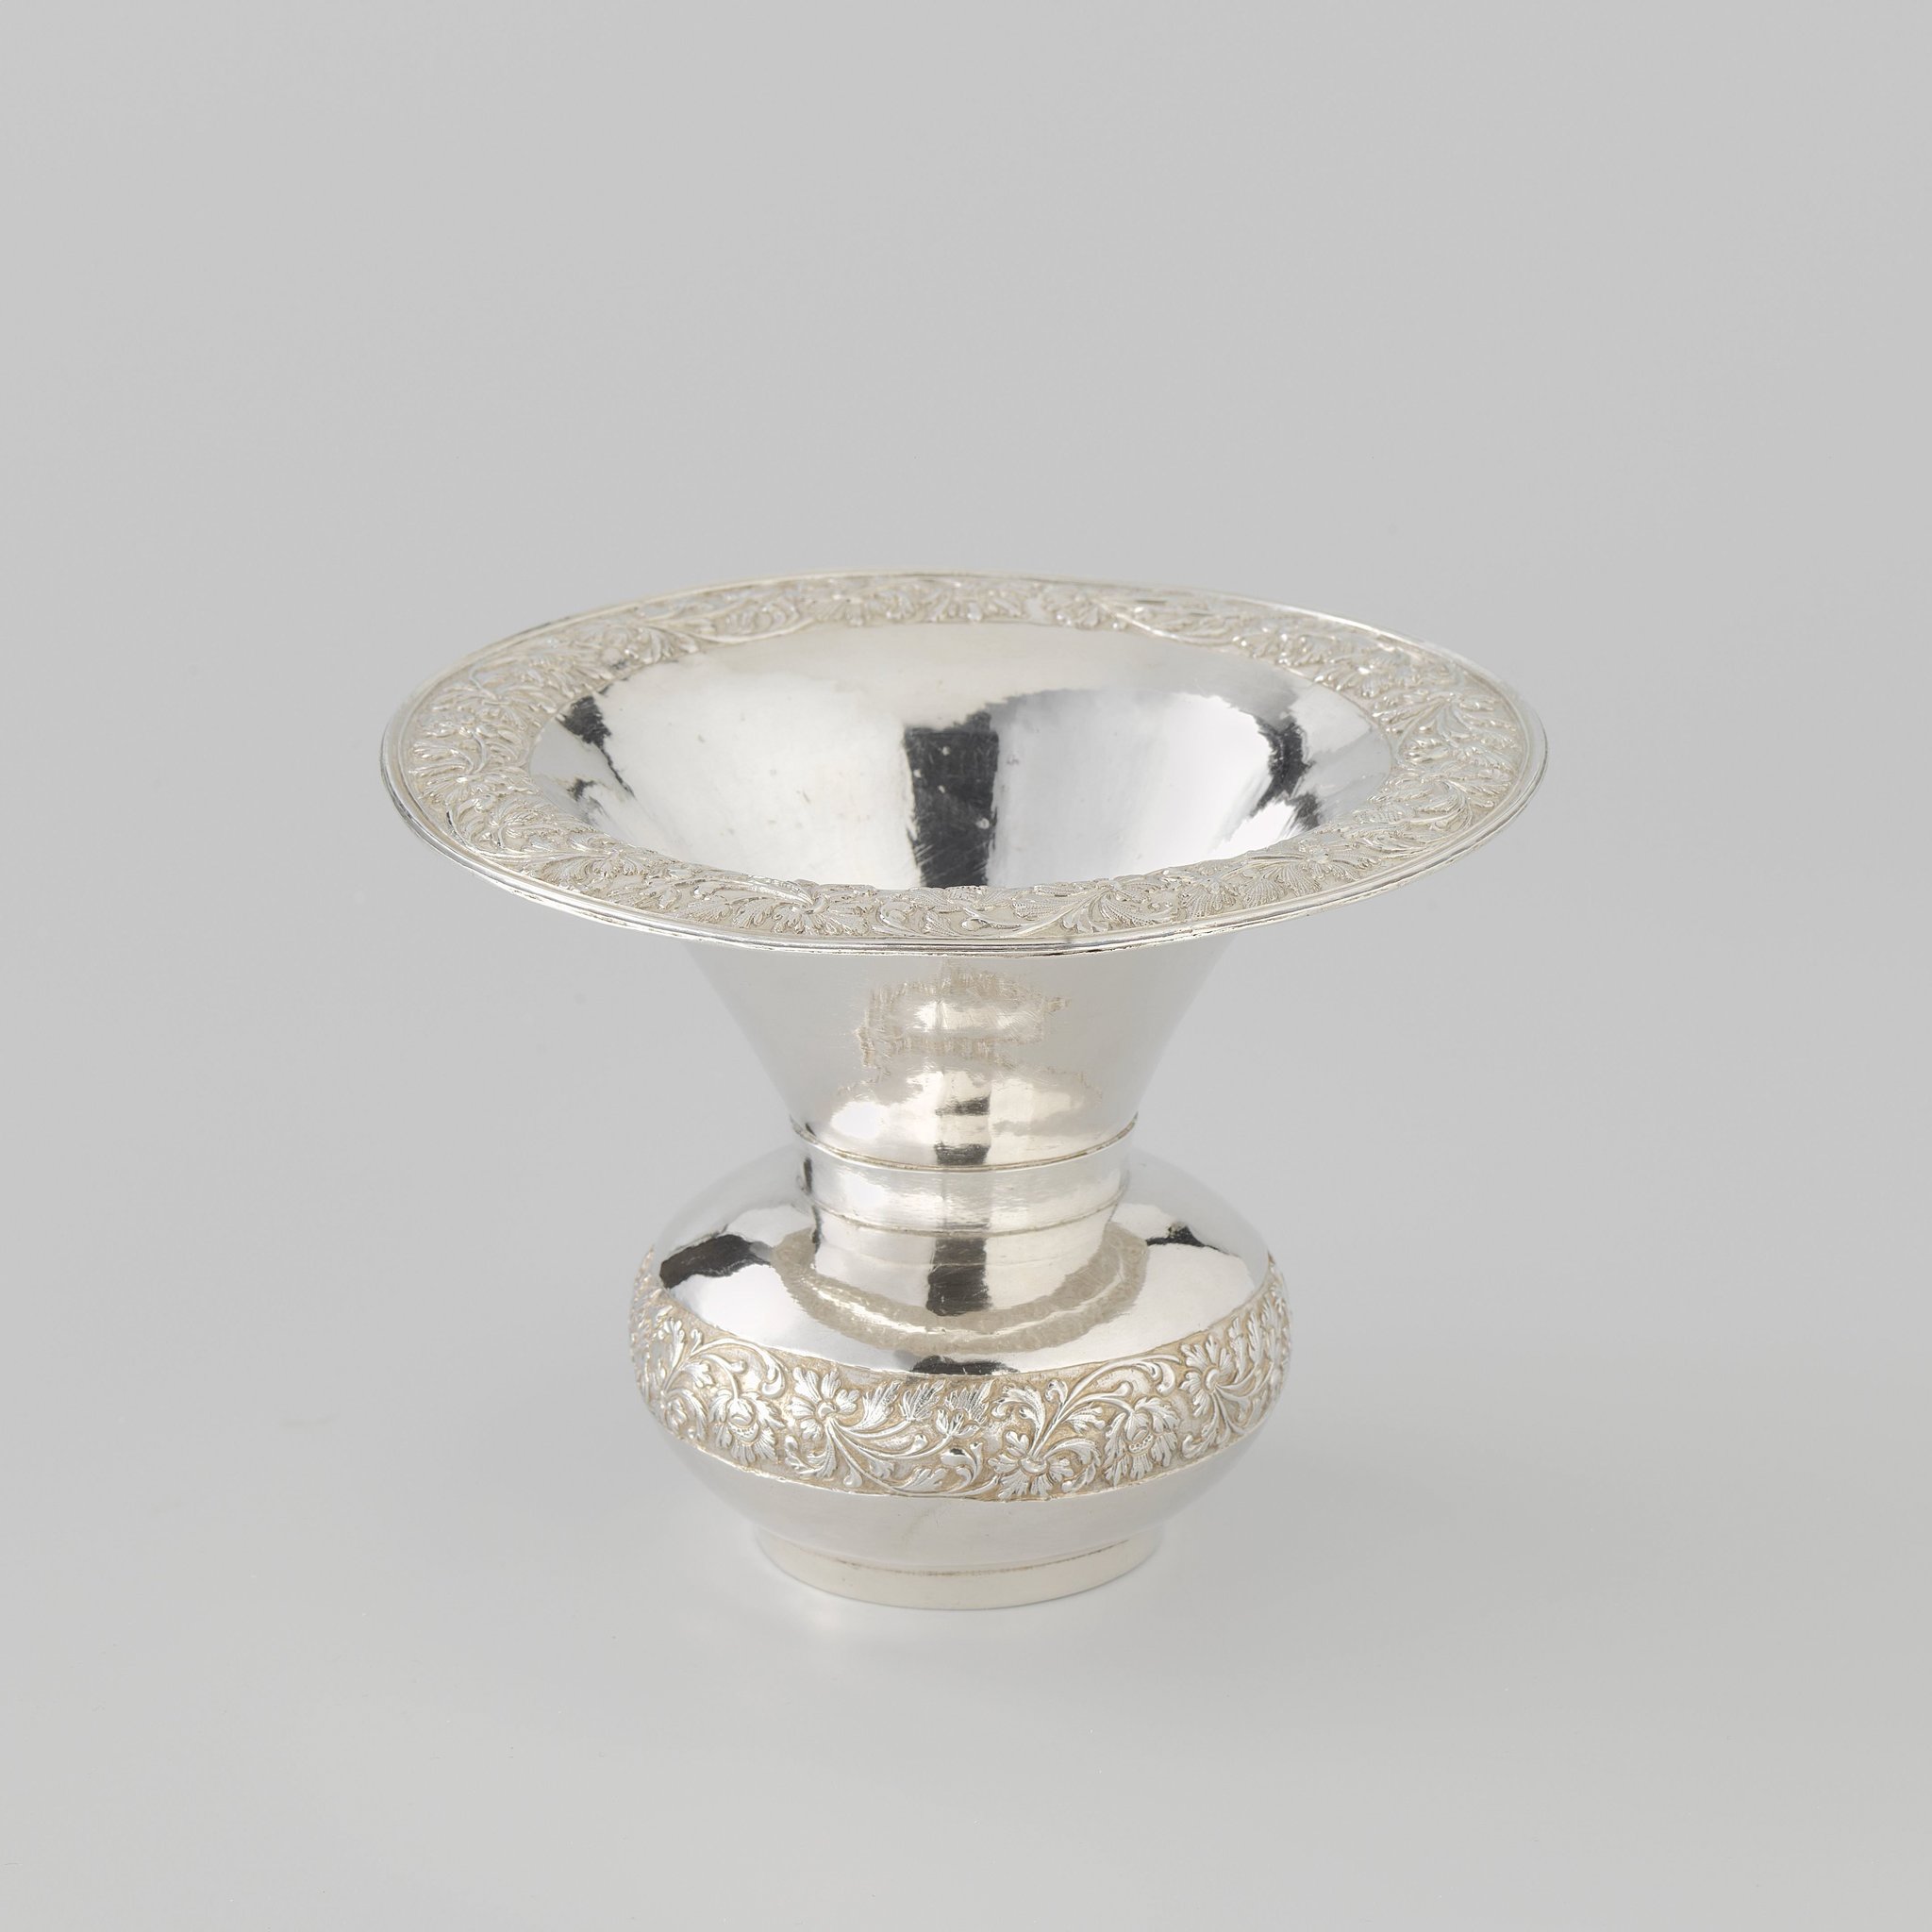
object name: spittoon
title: Kwispedoor van zilver met gedreven bloem- en bladranken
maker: Anonymous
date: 1650-1700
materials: silver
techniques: repoussé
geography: batavia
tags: foliage, tendrils, branches ~ ornament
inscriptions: mark: ‘drie zilvermerken’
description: Spittoon. Silver. Indonesia or Ceylon, c. 1680-1720. Purchased from Stichting Cultuurgeschiedenis Nederlanders Overzee.